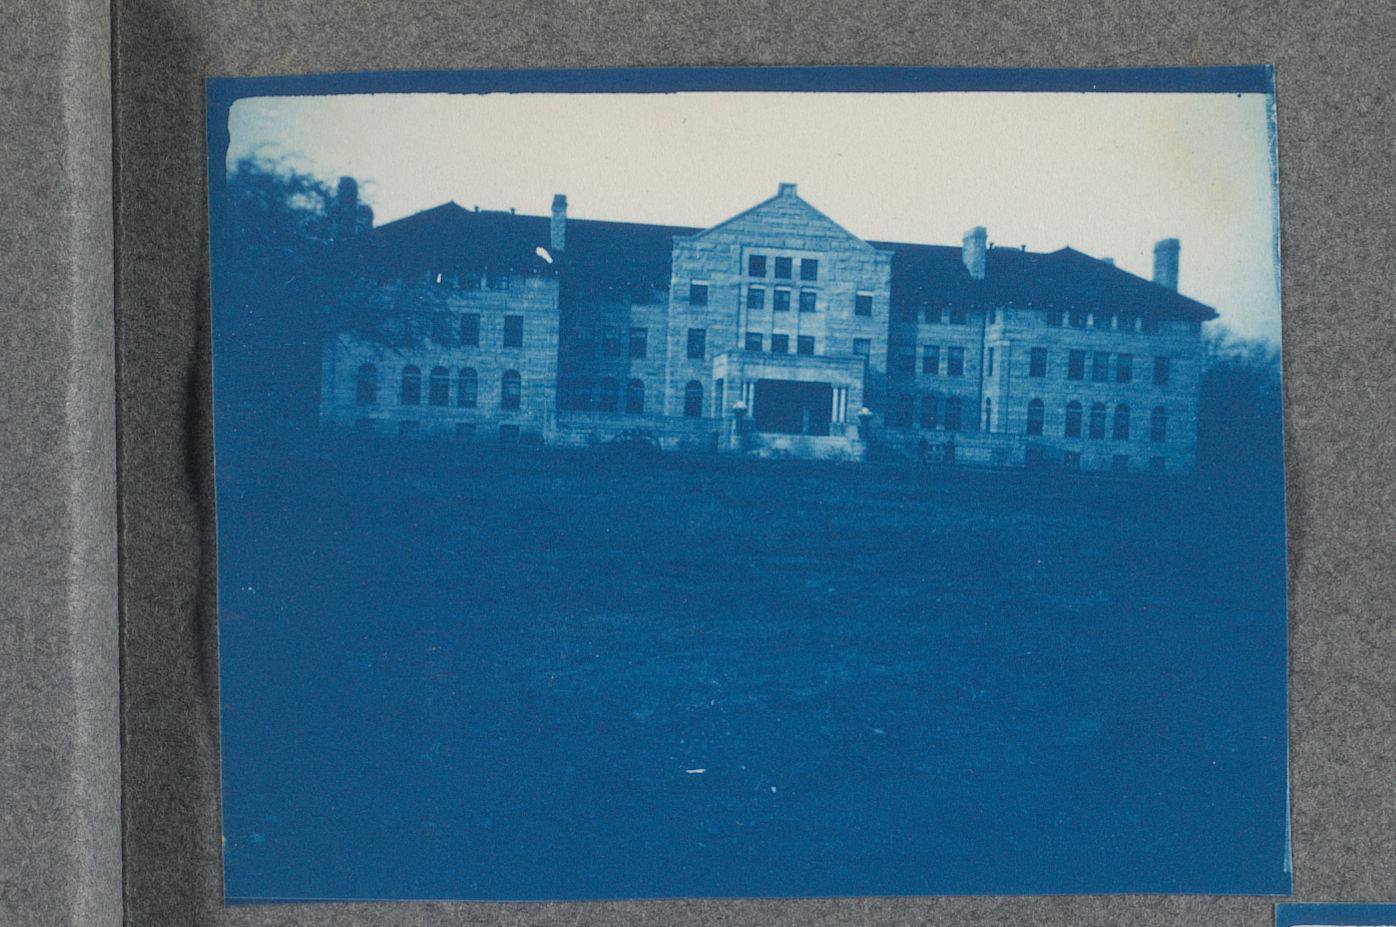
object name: photograph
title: Gebouw aan een grasveld, mogelijk op de campus van St. Johnsbury Academy in Vermont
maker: Anonymous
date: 1905-1915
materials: paper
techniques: cyanotype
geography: st. johnsbury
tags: university building, college